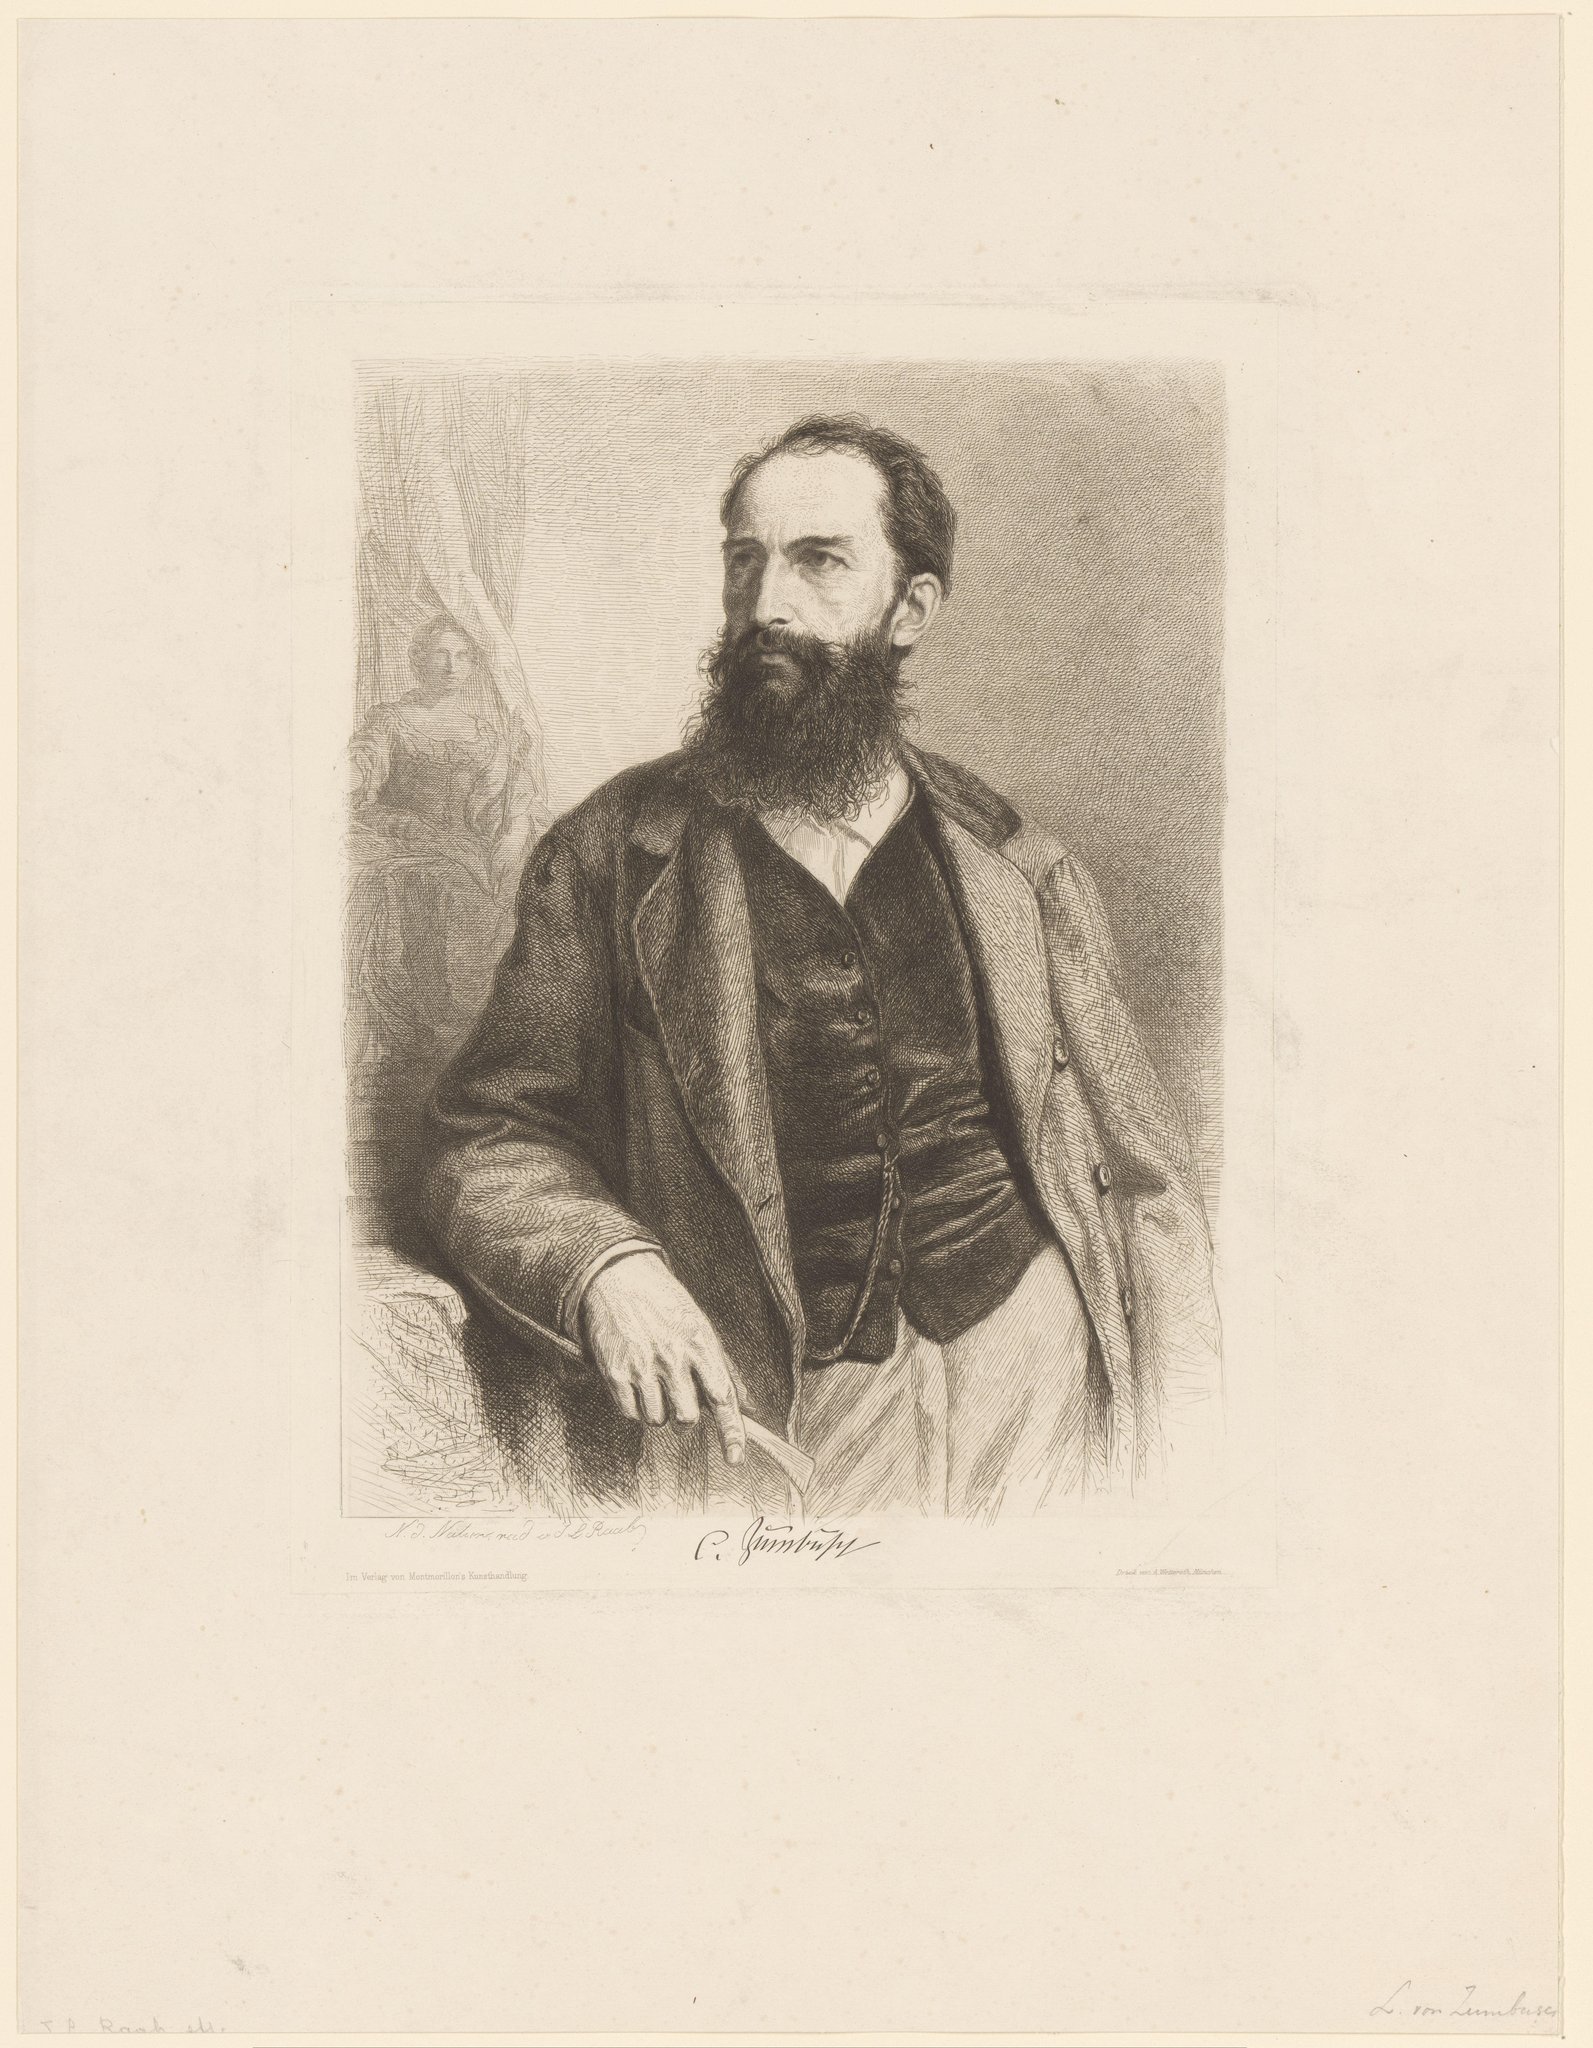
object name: print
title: Portret van Ludwig von Zumbusch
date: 1881-1899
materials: paper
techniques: etching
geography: munich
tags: painter, draughtsman, ludwig von zumbusch, portrait, self-portrait of painter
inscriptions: name, collector's mark: Lugt 2228